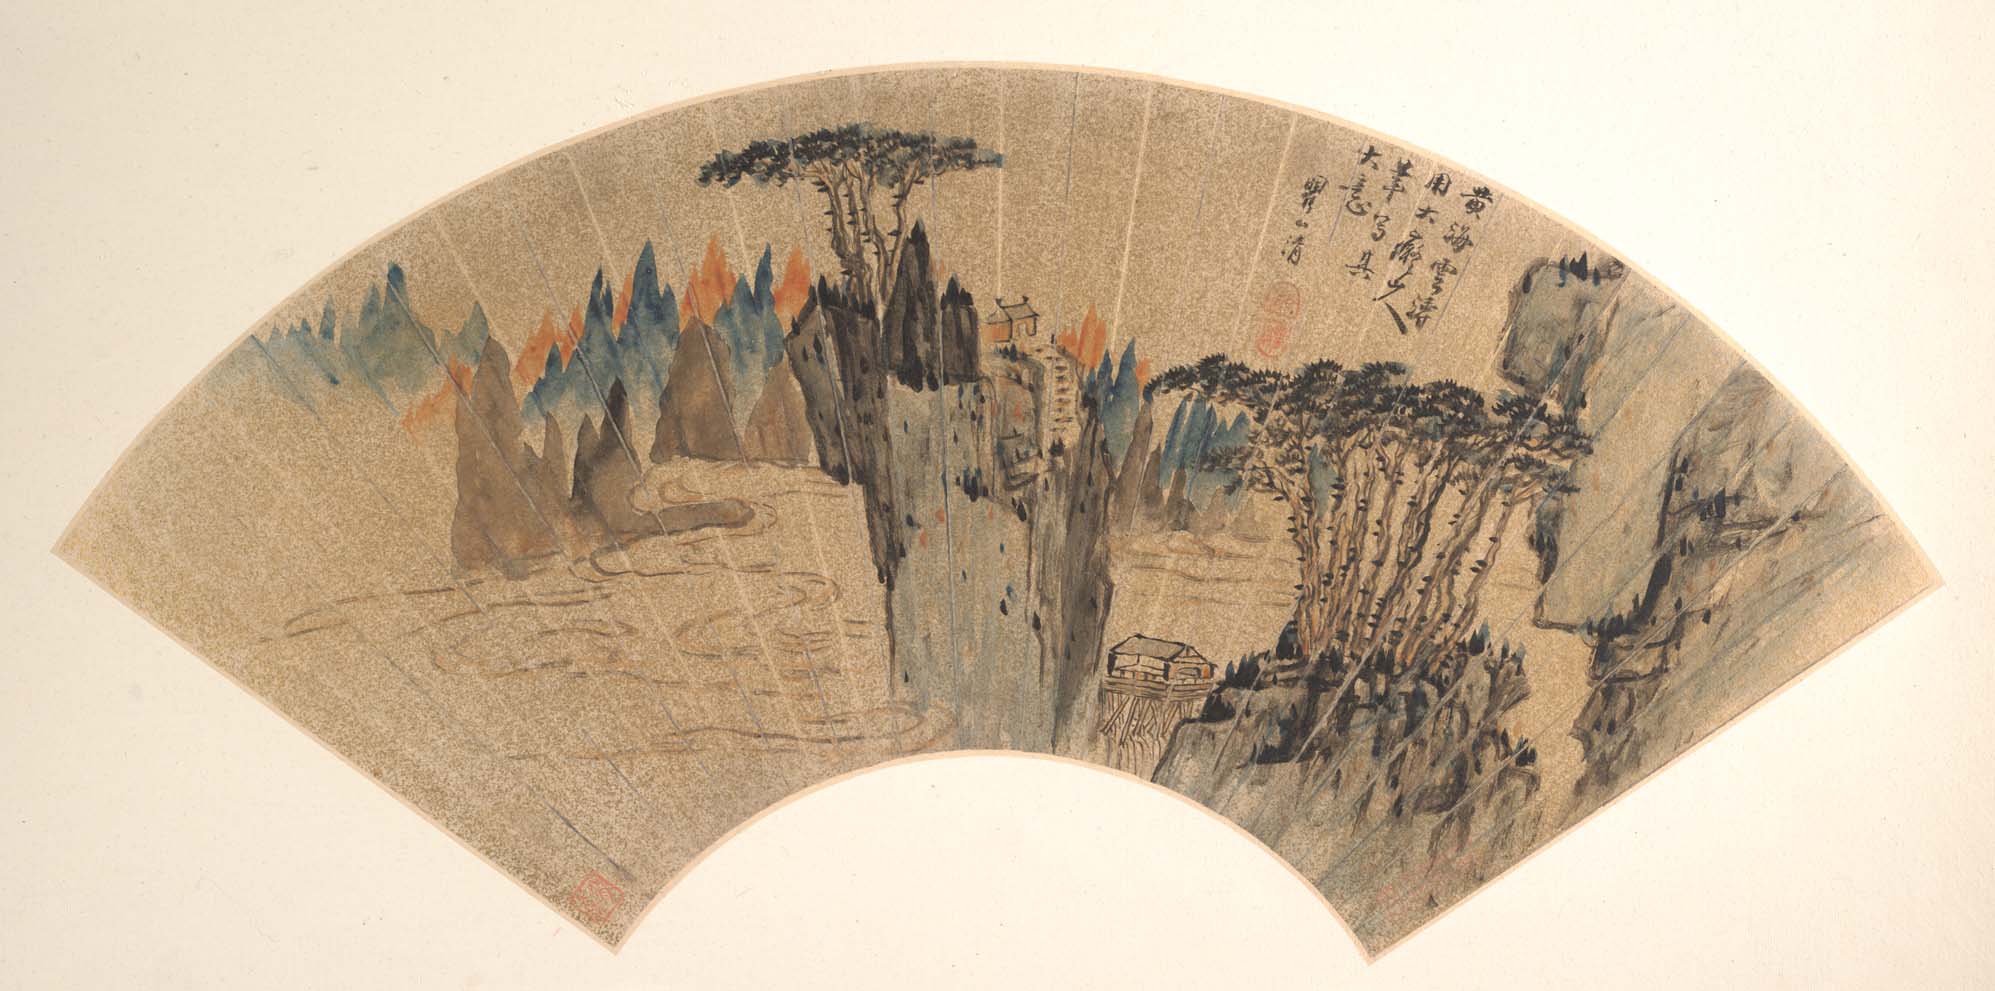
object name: folding fan mounted a an album leaf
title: Peaks of Mount Huang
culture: chinese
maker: mei qing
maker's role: artist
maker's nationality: chinese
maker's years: 1623-1697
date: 1623-1697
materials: gold, ink, paper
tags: mountains